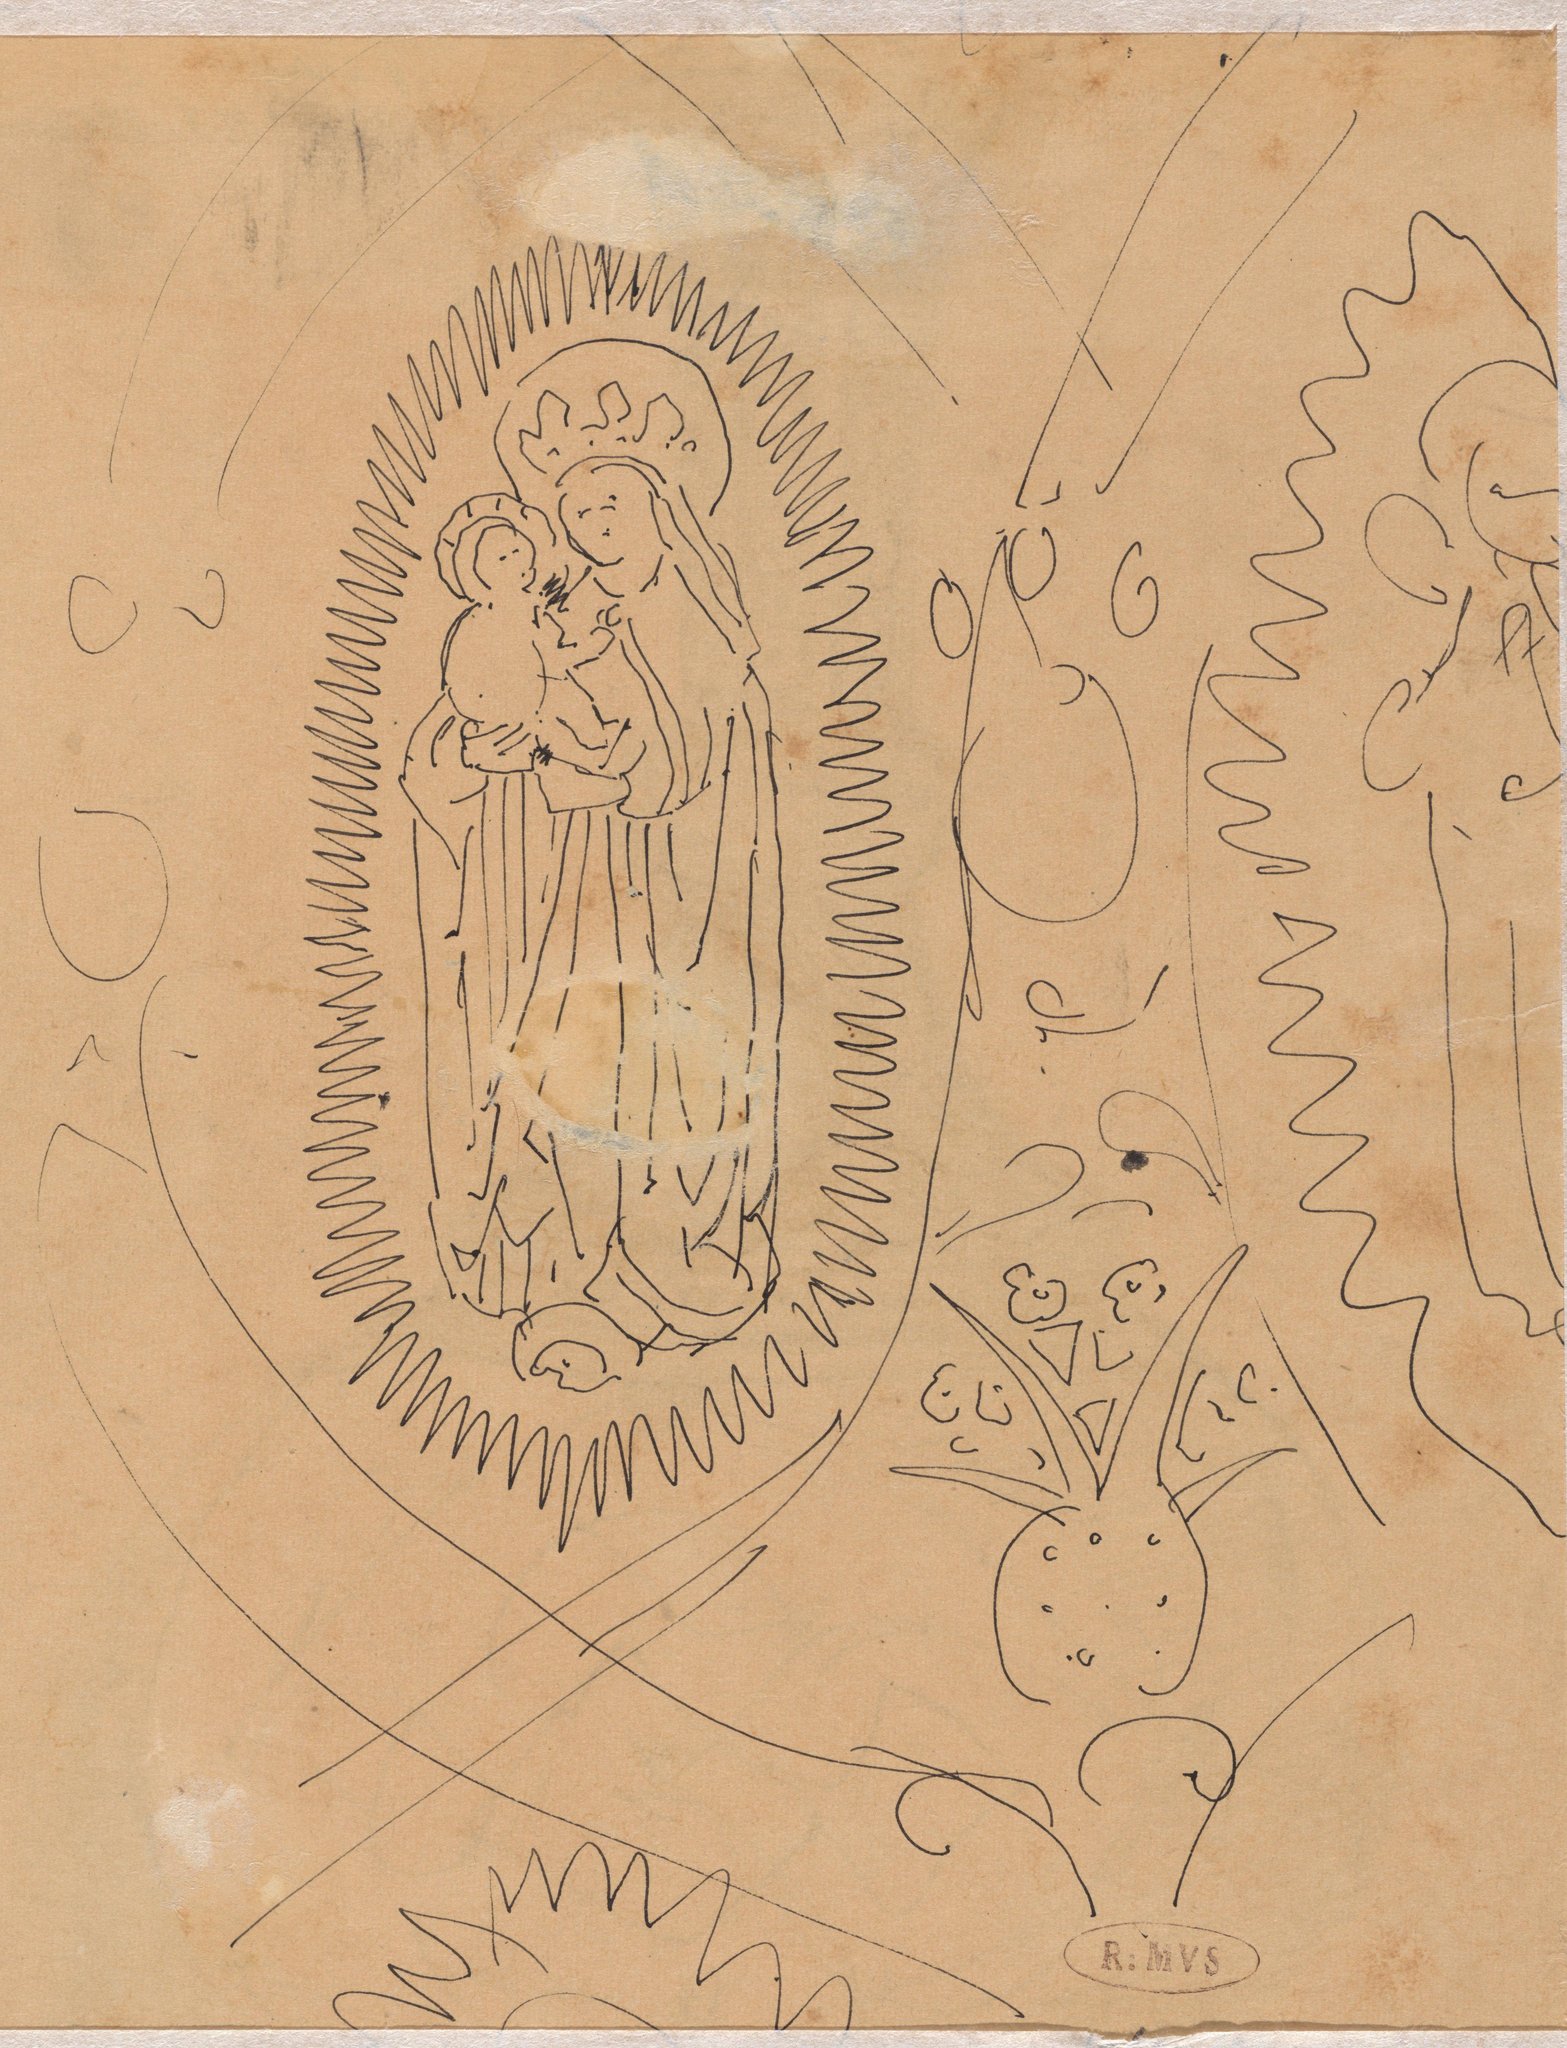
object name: drawing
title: Vijftiende eeuwse Perzische vaas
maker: theo nieuwenhuis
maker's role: designer, draughtsman, print maker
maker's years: 1866-1951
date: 1876-1951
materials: ink, paper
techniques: pen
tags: work of applied art (+ other non-european art developments), container of ceramics: jar, jug, pot, vase